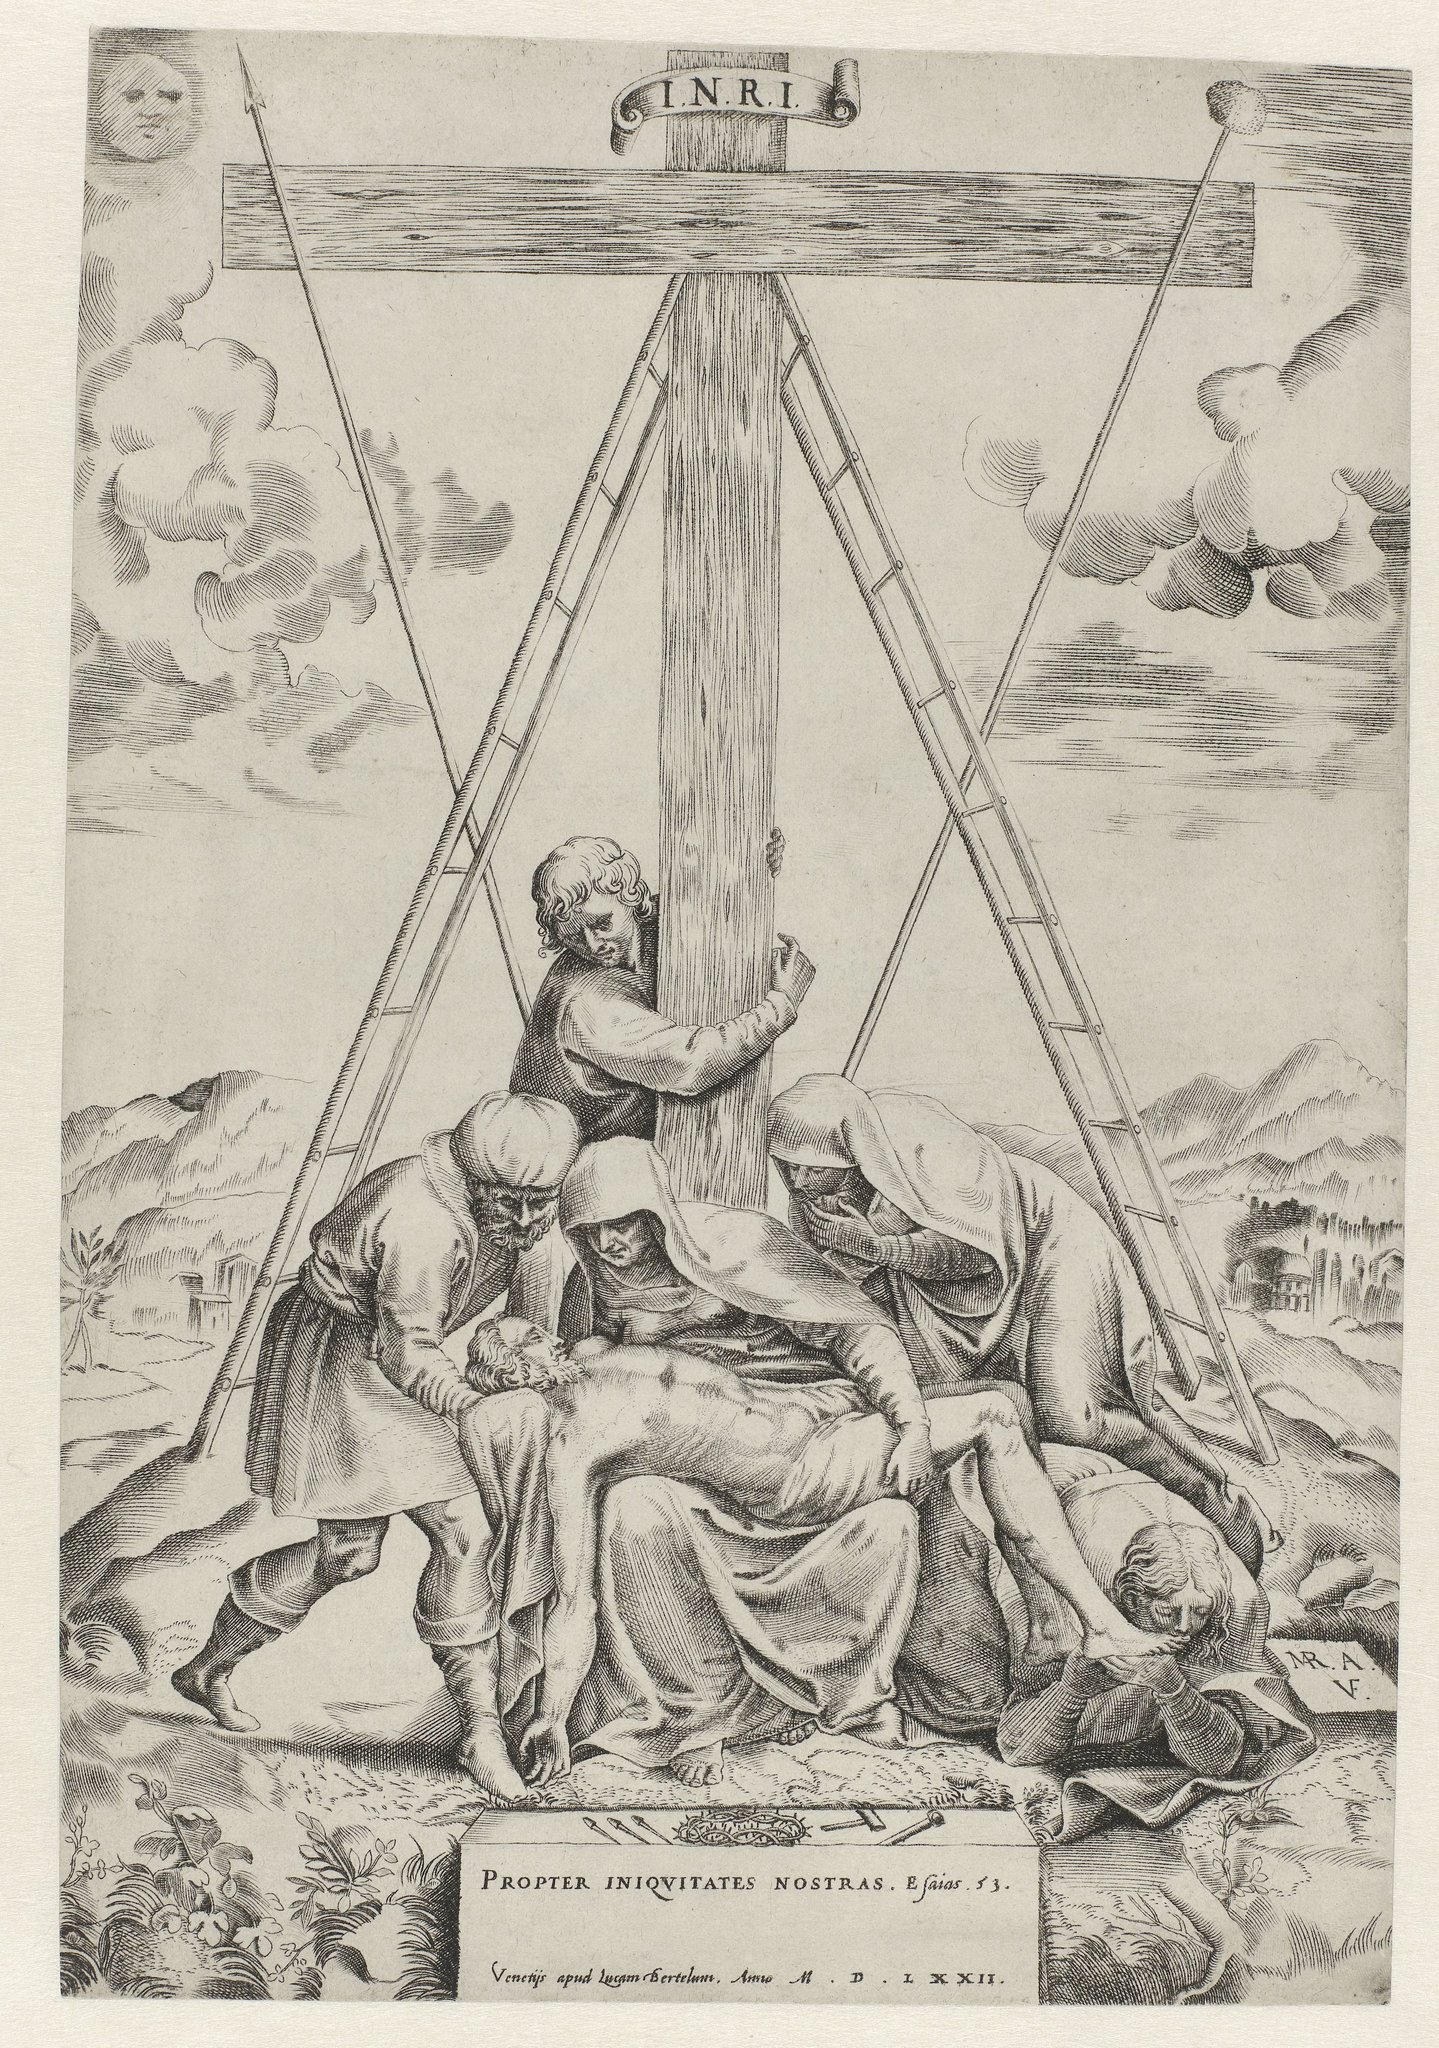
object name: print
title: Bewening van Christus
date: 1572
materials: paper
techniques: etching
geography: venice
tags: lamentation over the dead christ by his relatives and friends (christ usually without crown of thorns)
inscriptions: collector's mark: Lugt 2760, collector's mark: Lugt 2228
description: Maria met het lichaam van de dode Christus op schoot onder het kruis omgeven door volgelingen. Maria Magdalena kust de voeten van Christus. De piramidale compositie wordt geaccentueerd door de twee ladders die tegen het kruis staan, met daarachter een lans en een stok met een spons. Op de voorgrond op een sokkel liggen de doornenkroon, spijkers en een hamer. Op de sokkel de tekst: Propter iniquitates nostras. Esaias. 53.